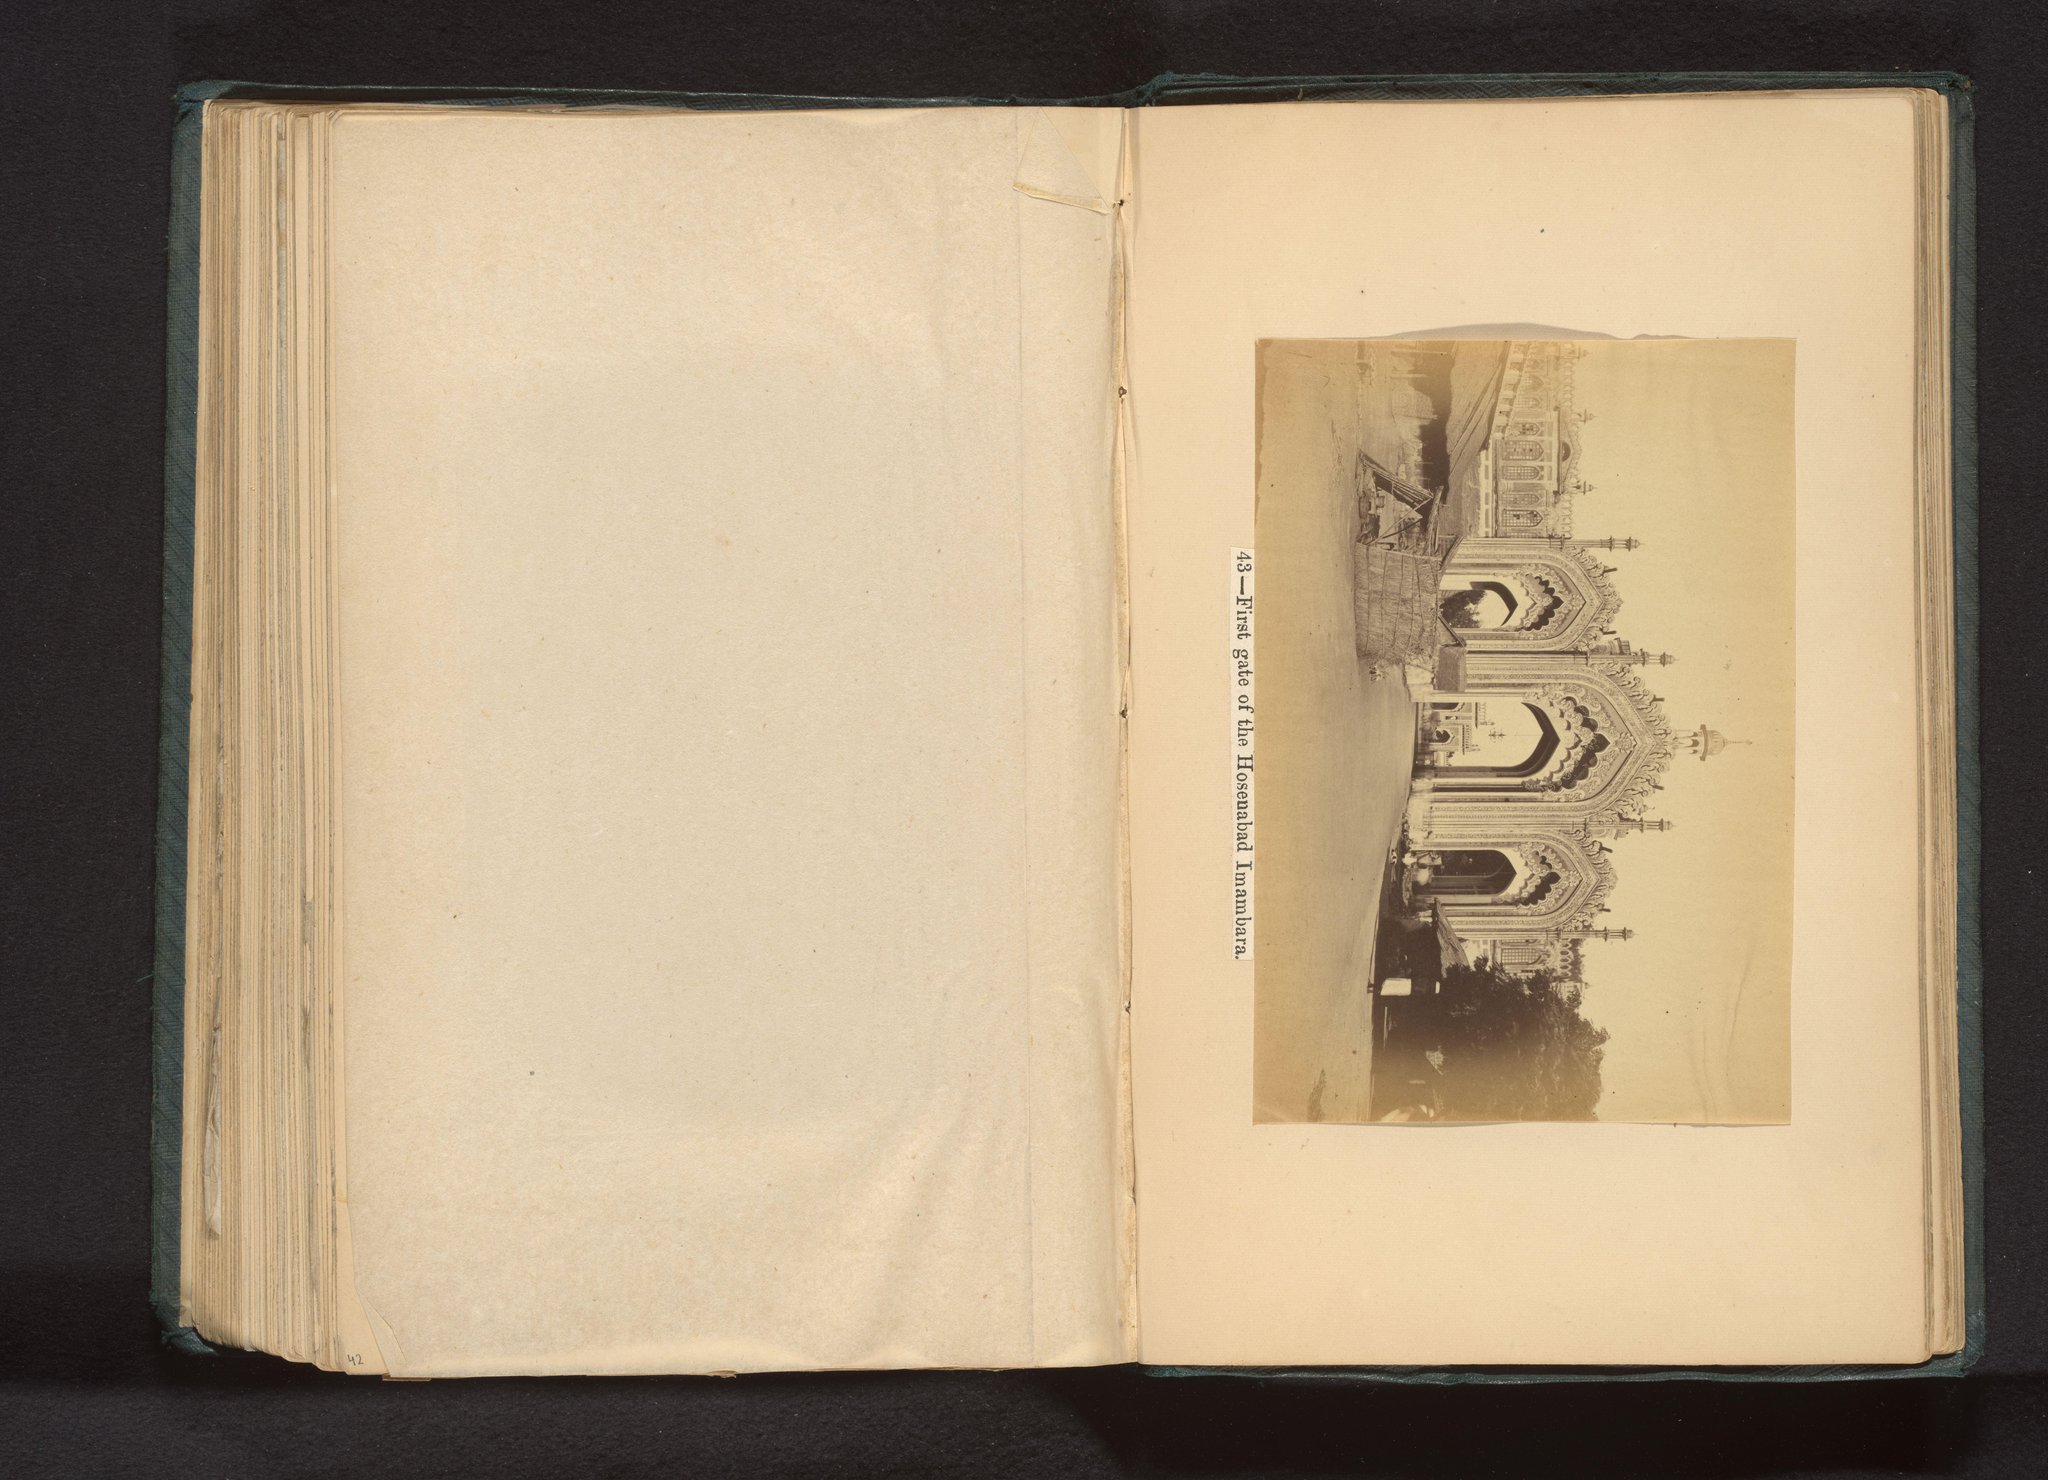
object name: page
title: First gate of the Hosenabad Imambara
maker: darogha ubbas alli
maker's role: fotograaf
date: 1864-1874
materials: photographic support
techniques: albumen print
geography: lucknow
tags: gate, entrance, temple, shrine ~ islam, mohammedanism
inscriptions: number: ‘43’